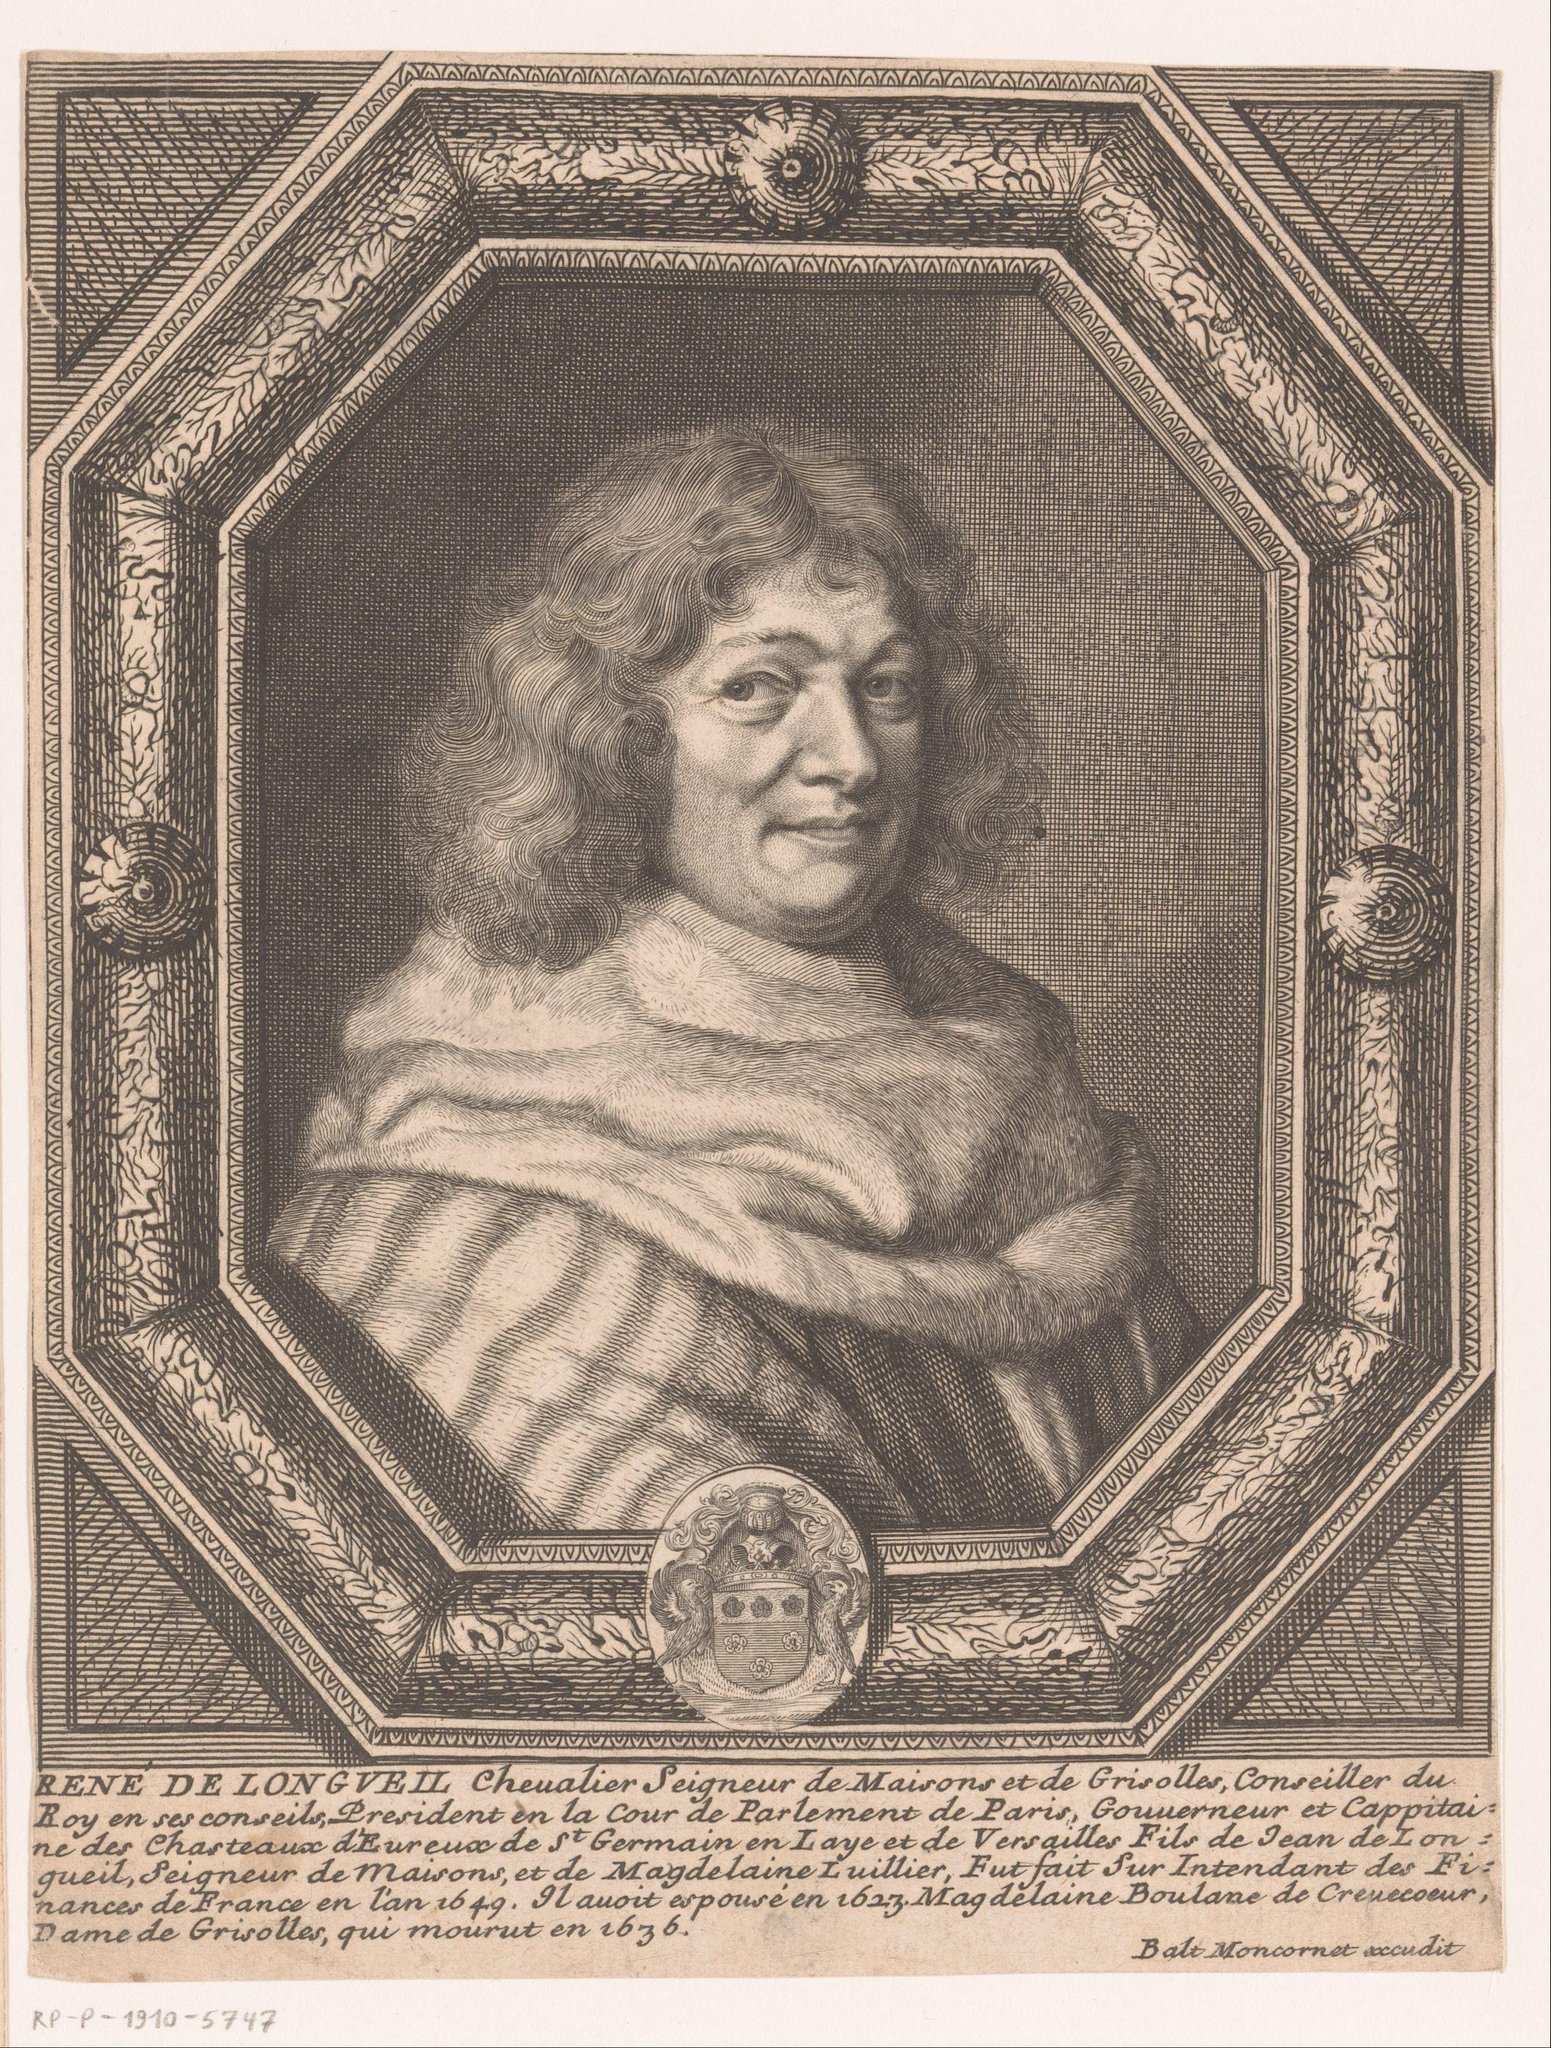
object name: print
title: Portret van René de Longueil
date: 1649-1668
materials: paper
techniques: engraving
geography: paris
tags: rené de longueil, official; civil servant; functionary (in general), historical persons, armorial bearing, heraldry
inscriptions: collector's mark: Lugt 2228